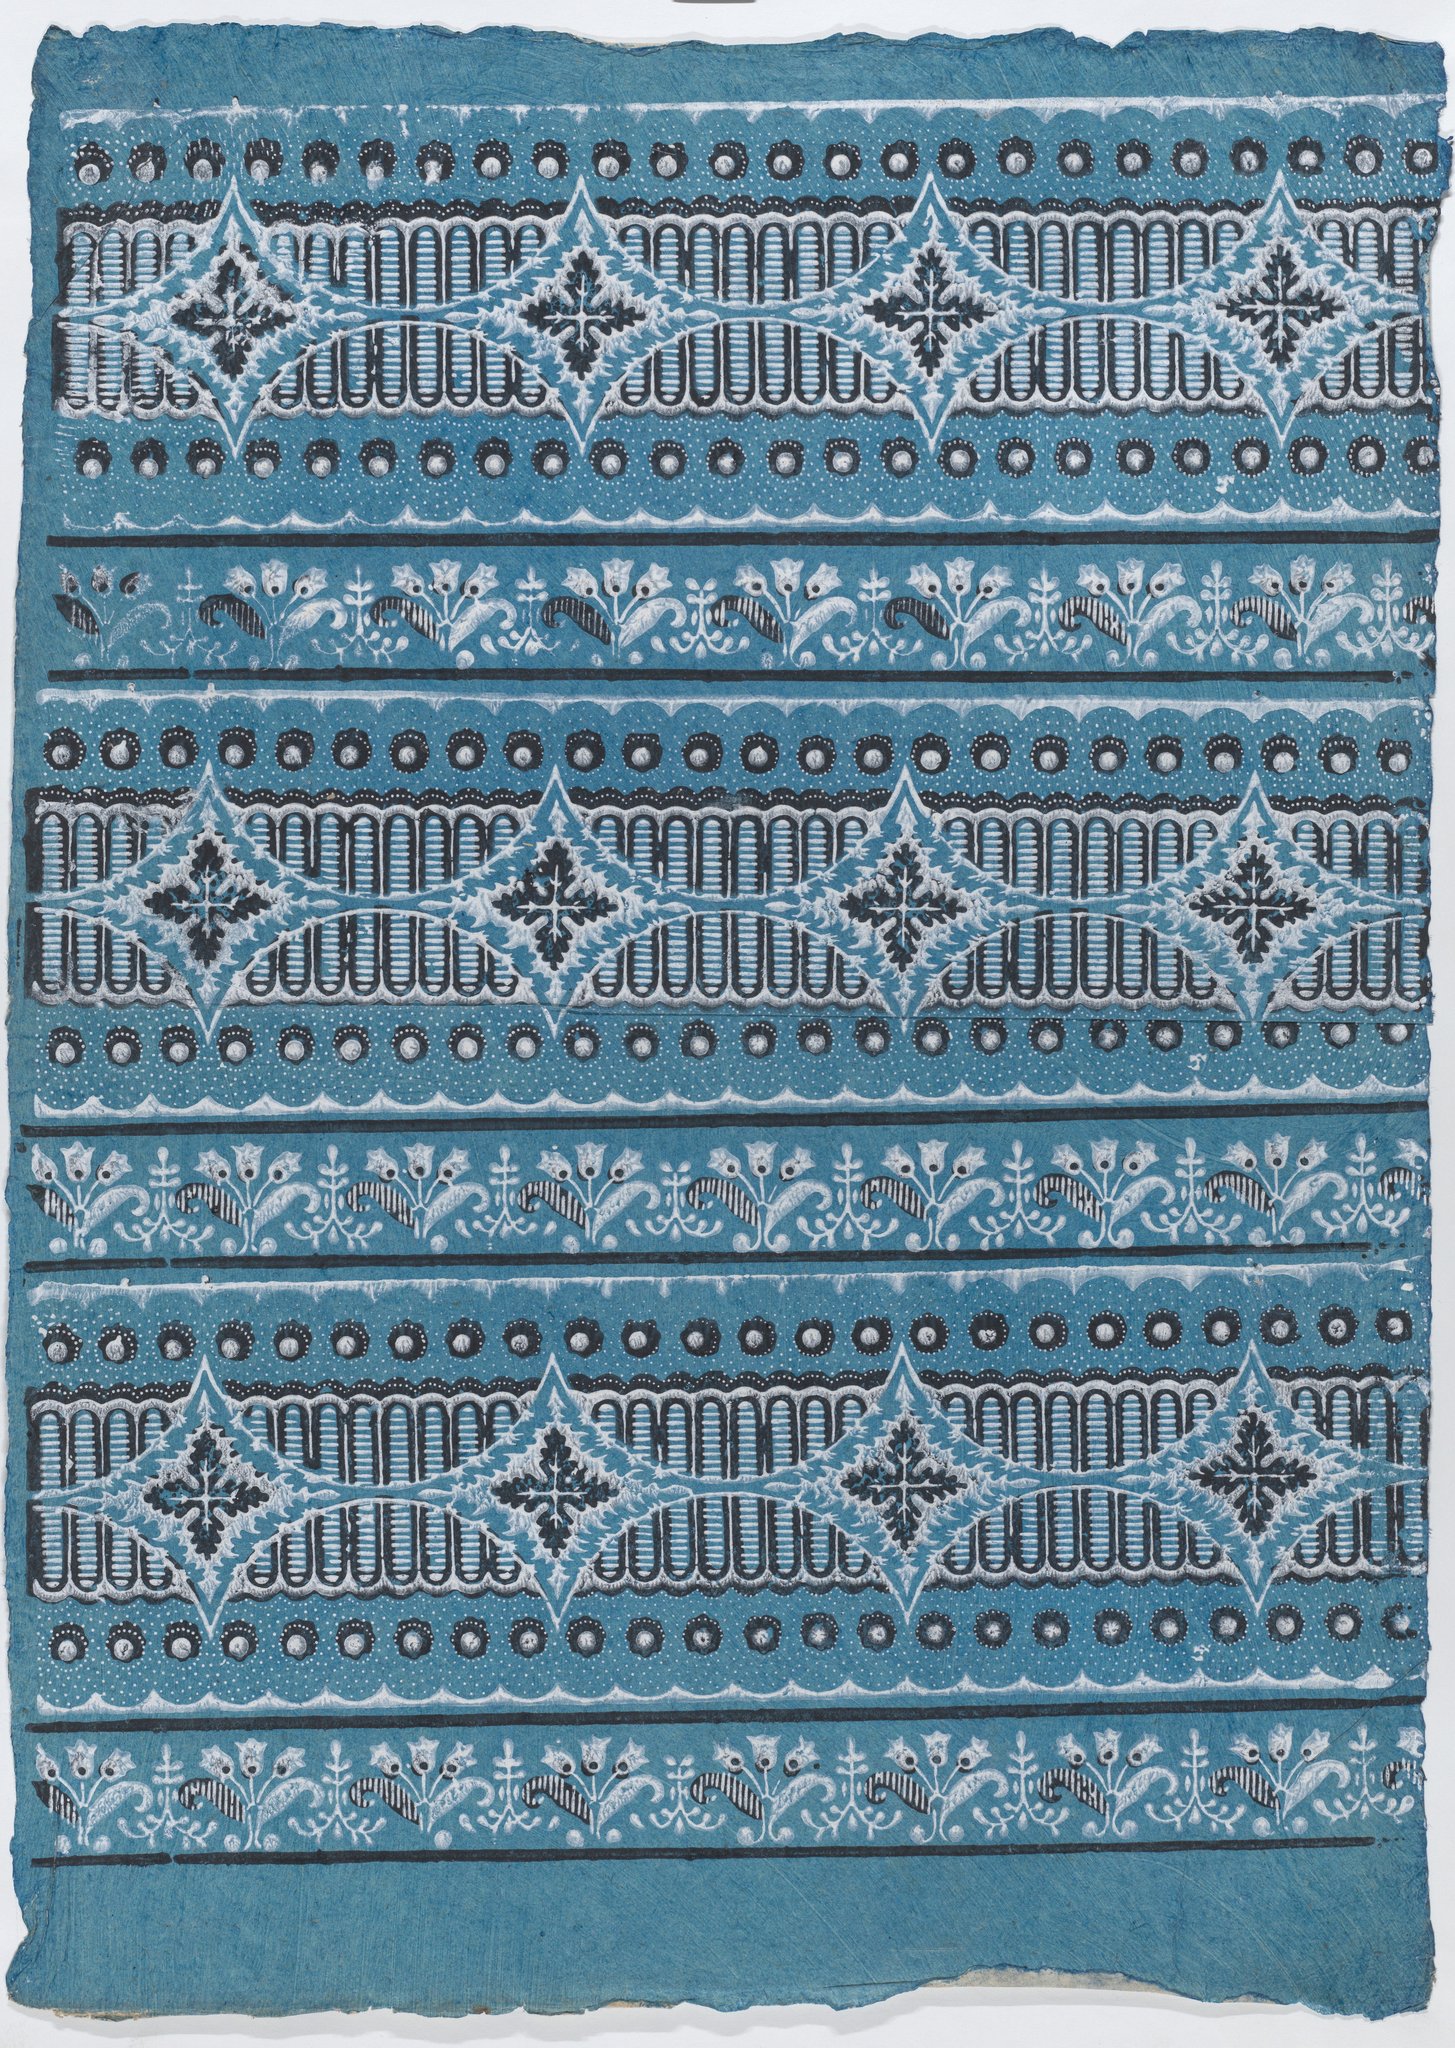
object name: print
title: Sheet with four borders with a floral, dot, and stripe pattern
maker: Anonymous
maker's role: artist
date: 1767-1866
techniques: relief print